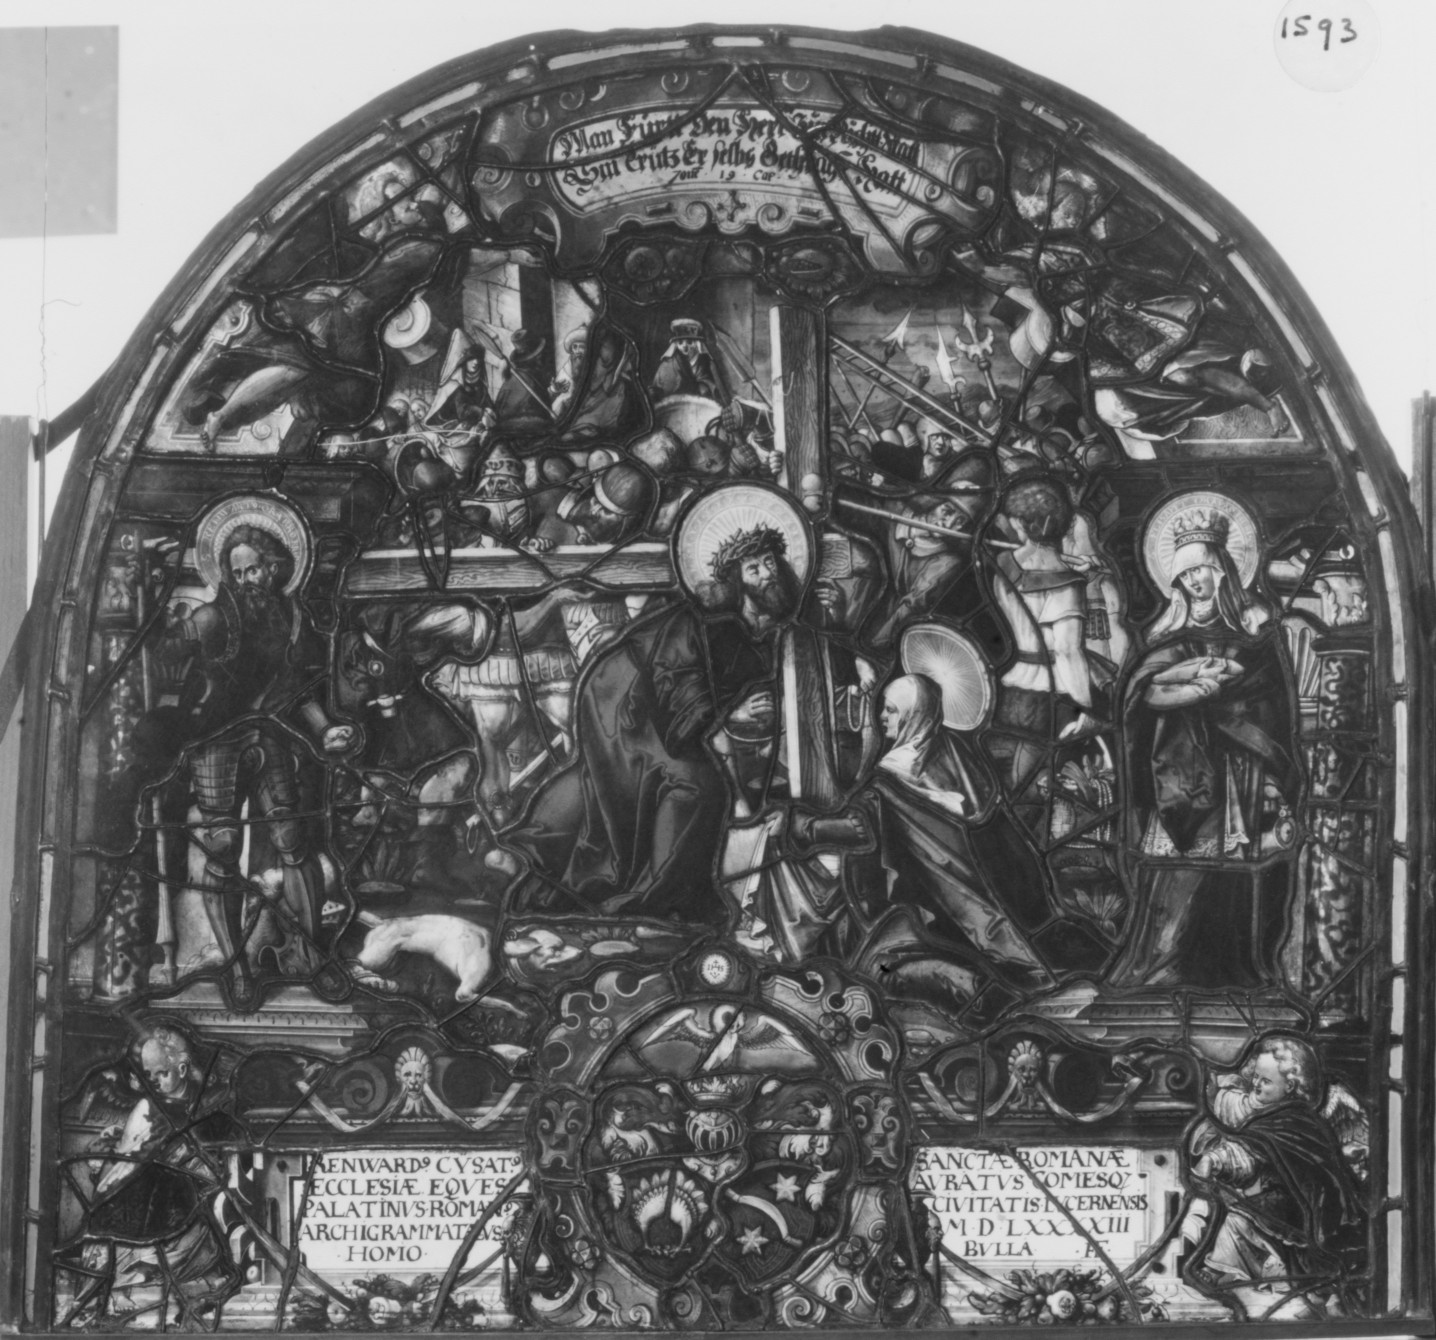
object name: panel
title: Christ Carrying the Cross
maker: franz fallenter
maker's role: artist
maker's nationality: german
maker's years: 1550-1616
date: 1593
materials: glass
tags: soldiers,christ,cross,coat of arms